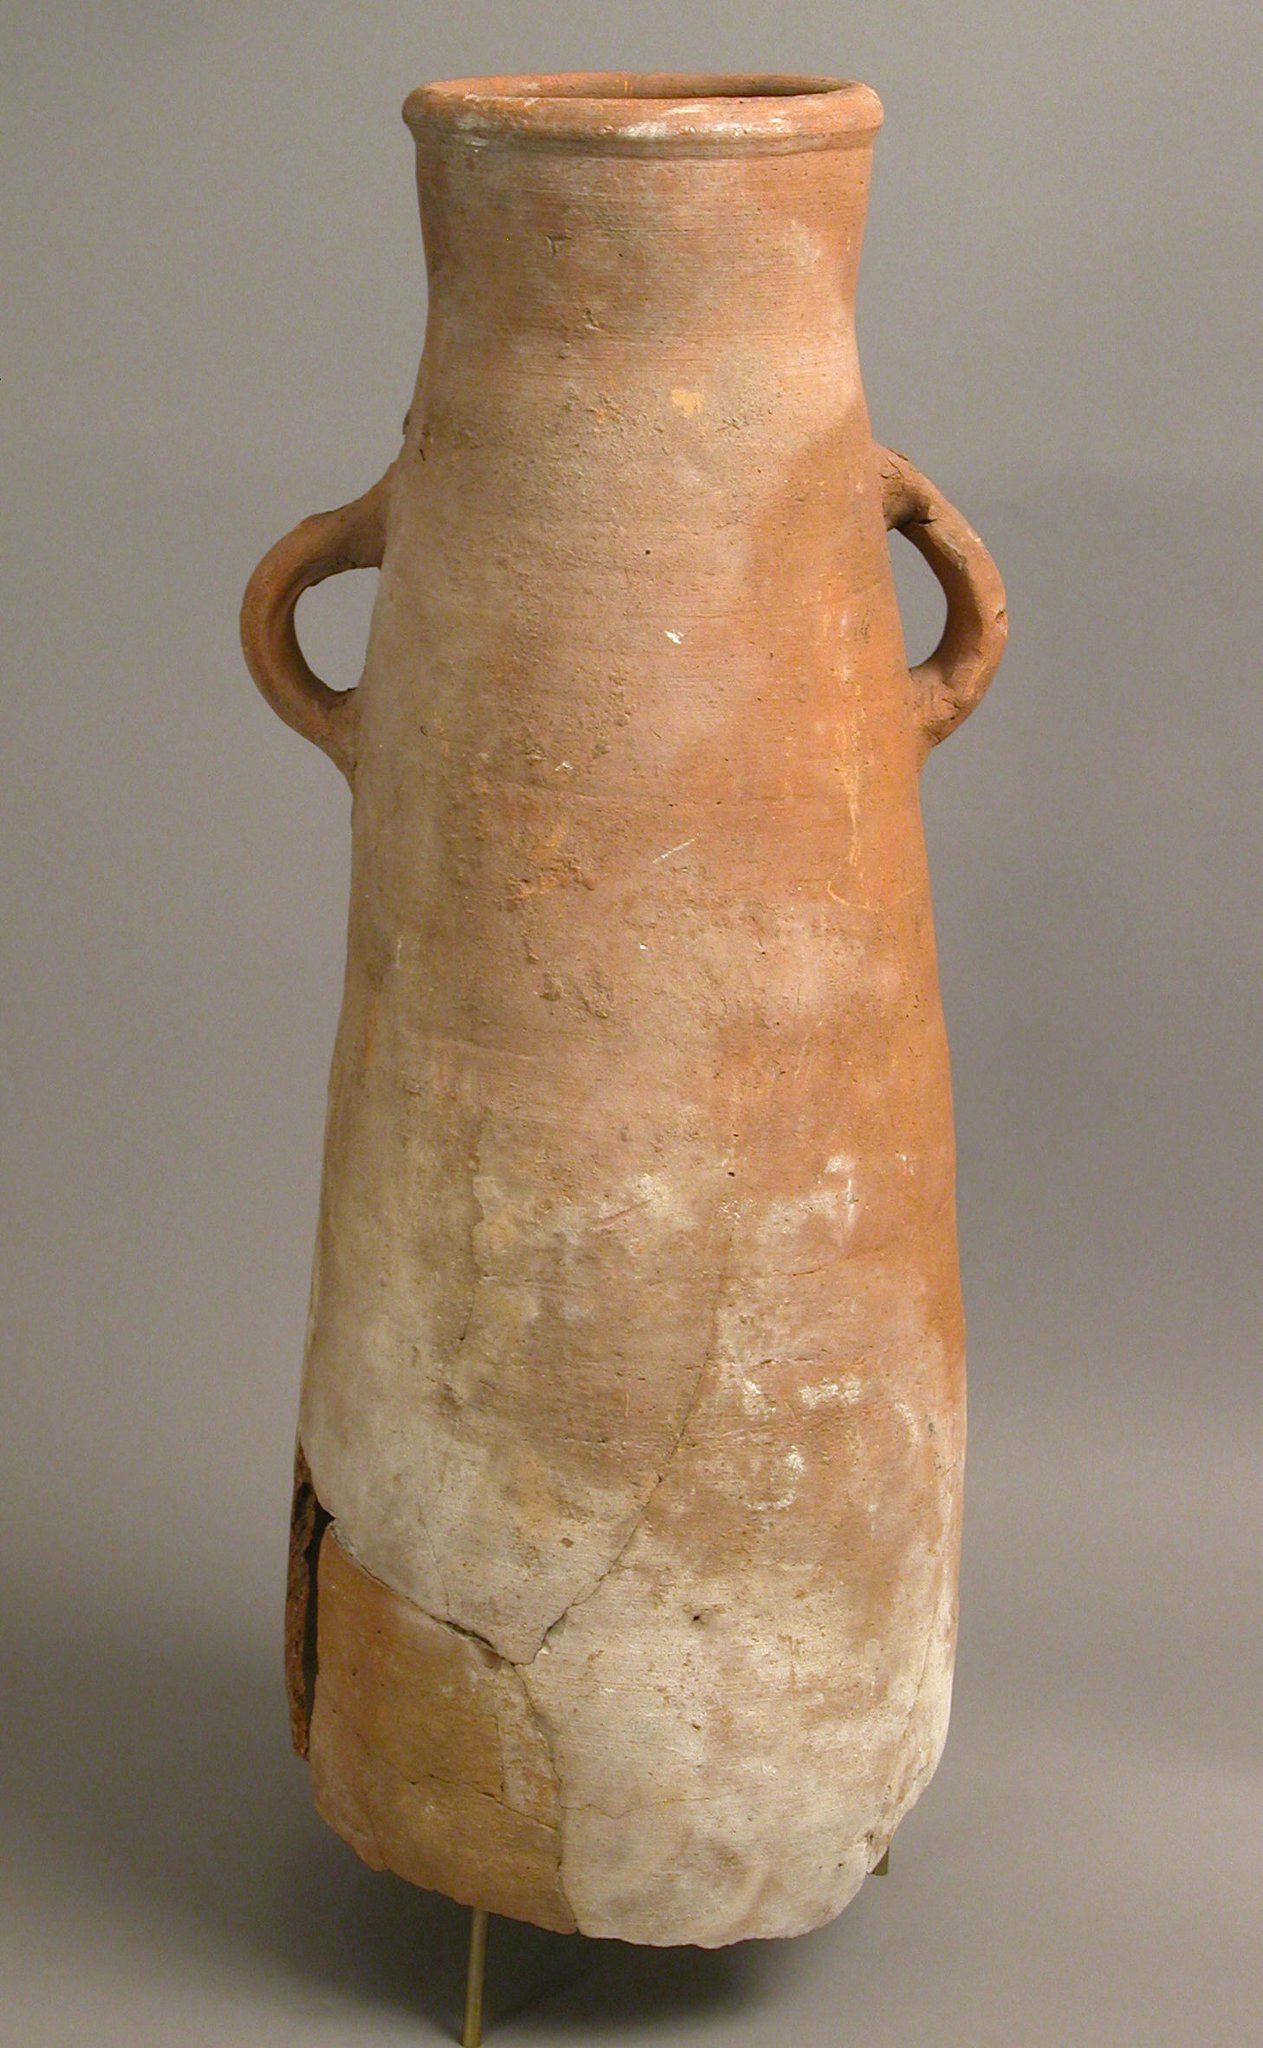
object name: amphora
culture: coptic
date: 301-700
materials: earthenware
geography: egypt